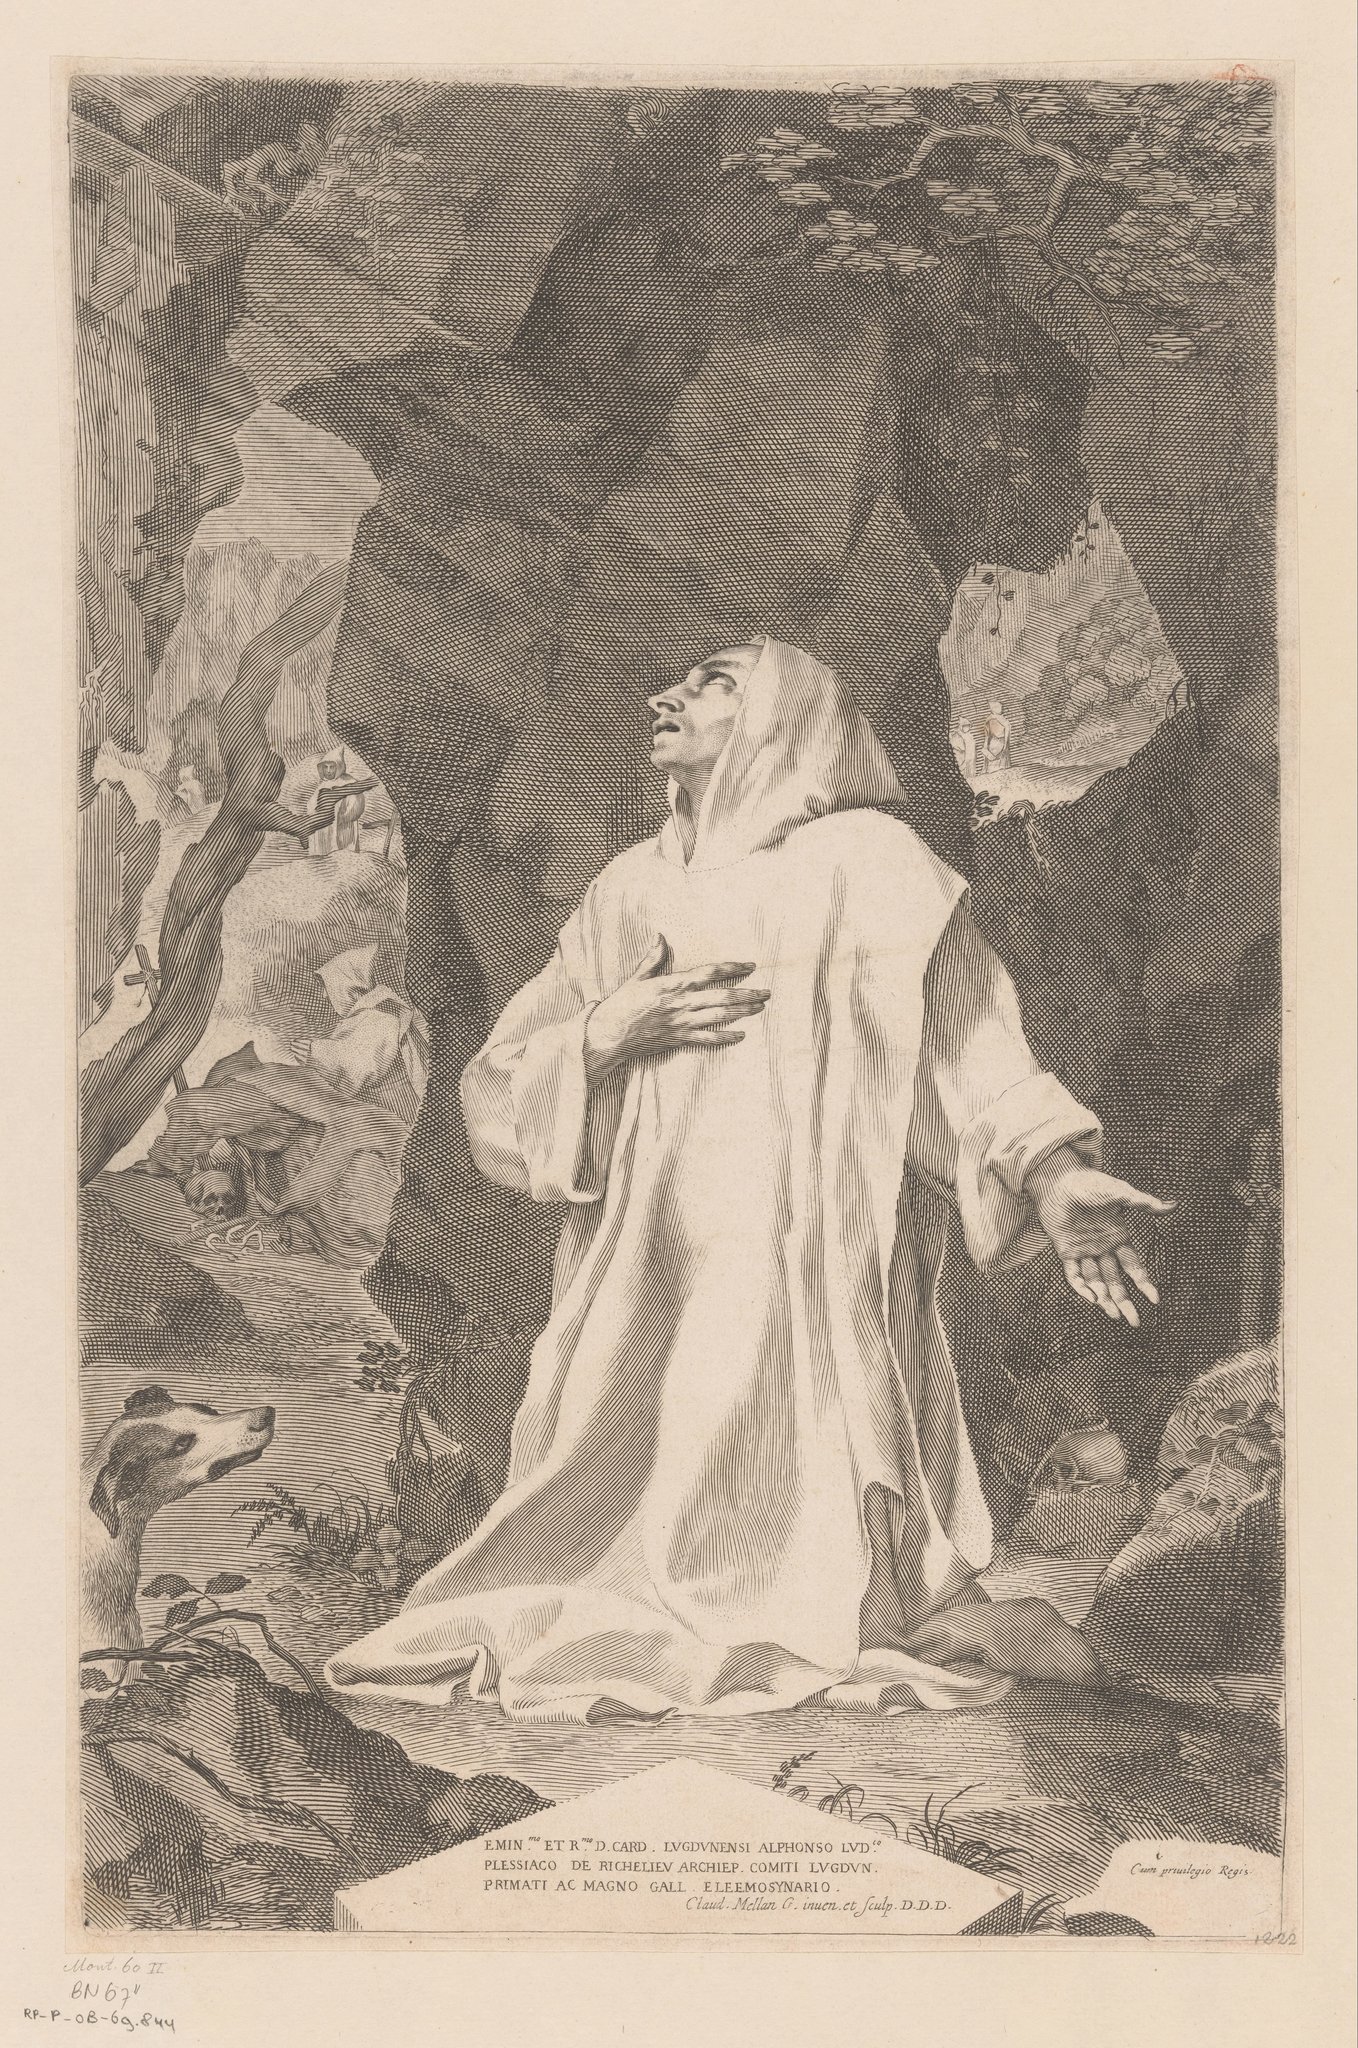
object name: print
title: H. Bruno geknield in een grot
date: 1608-1688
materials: paper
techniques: engraving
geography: france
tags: the founder of the order of the carthusians, bruno; possible attributes: cross, finger at lips, lily, mitre at his feet, olive-branch, ray of light, skull, (seven) star(s), cave, grotto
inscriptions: collector's mark: Lugt 240